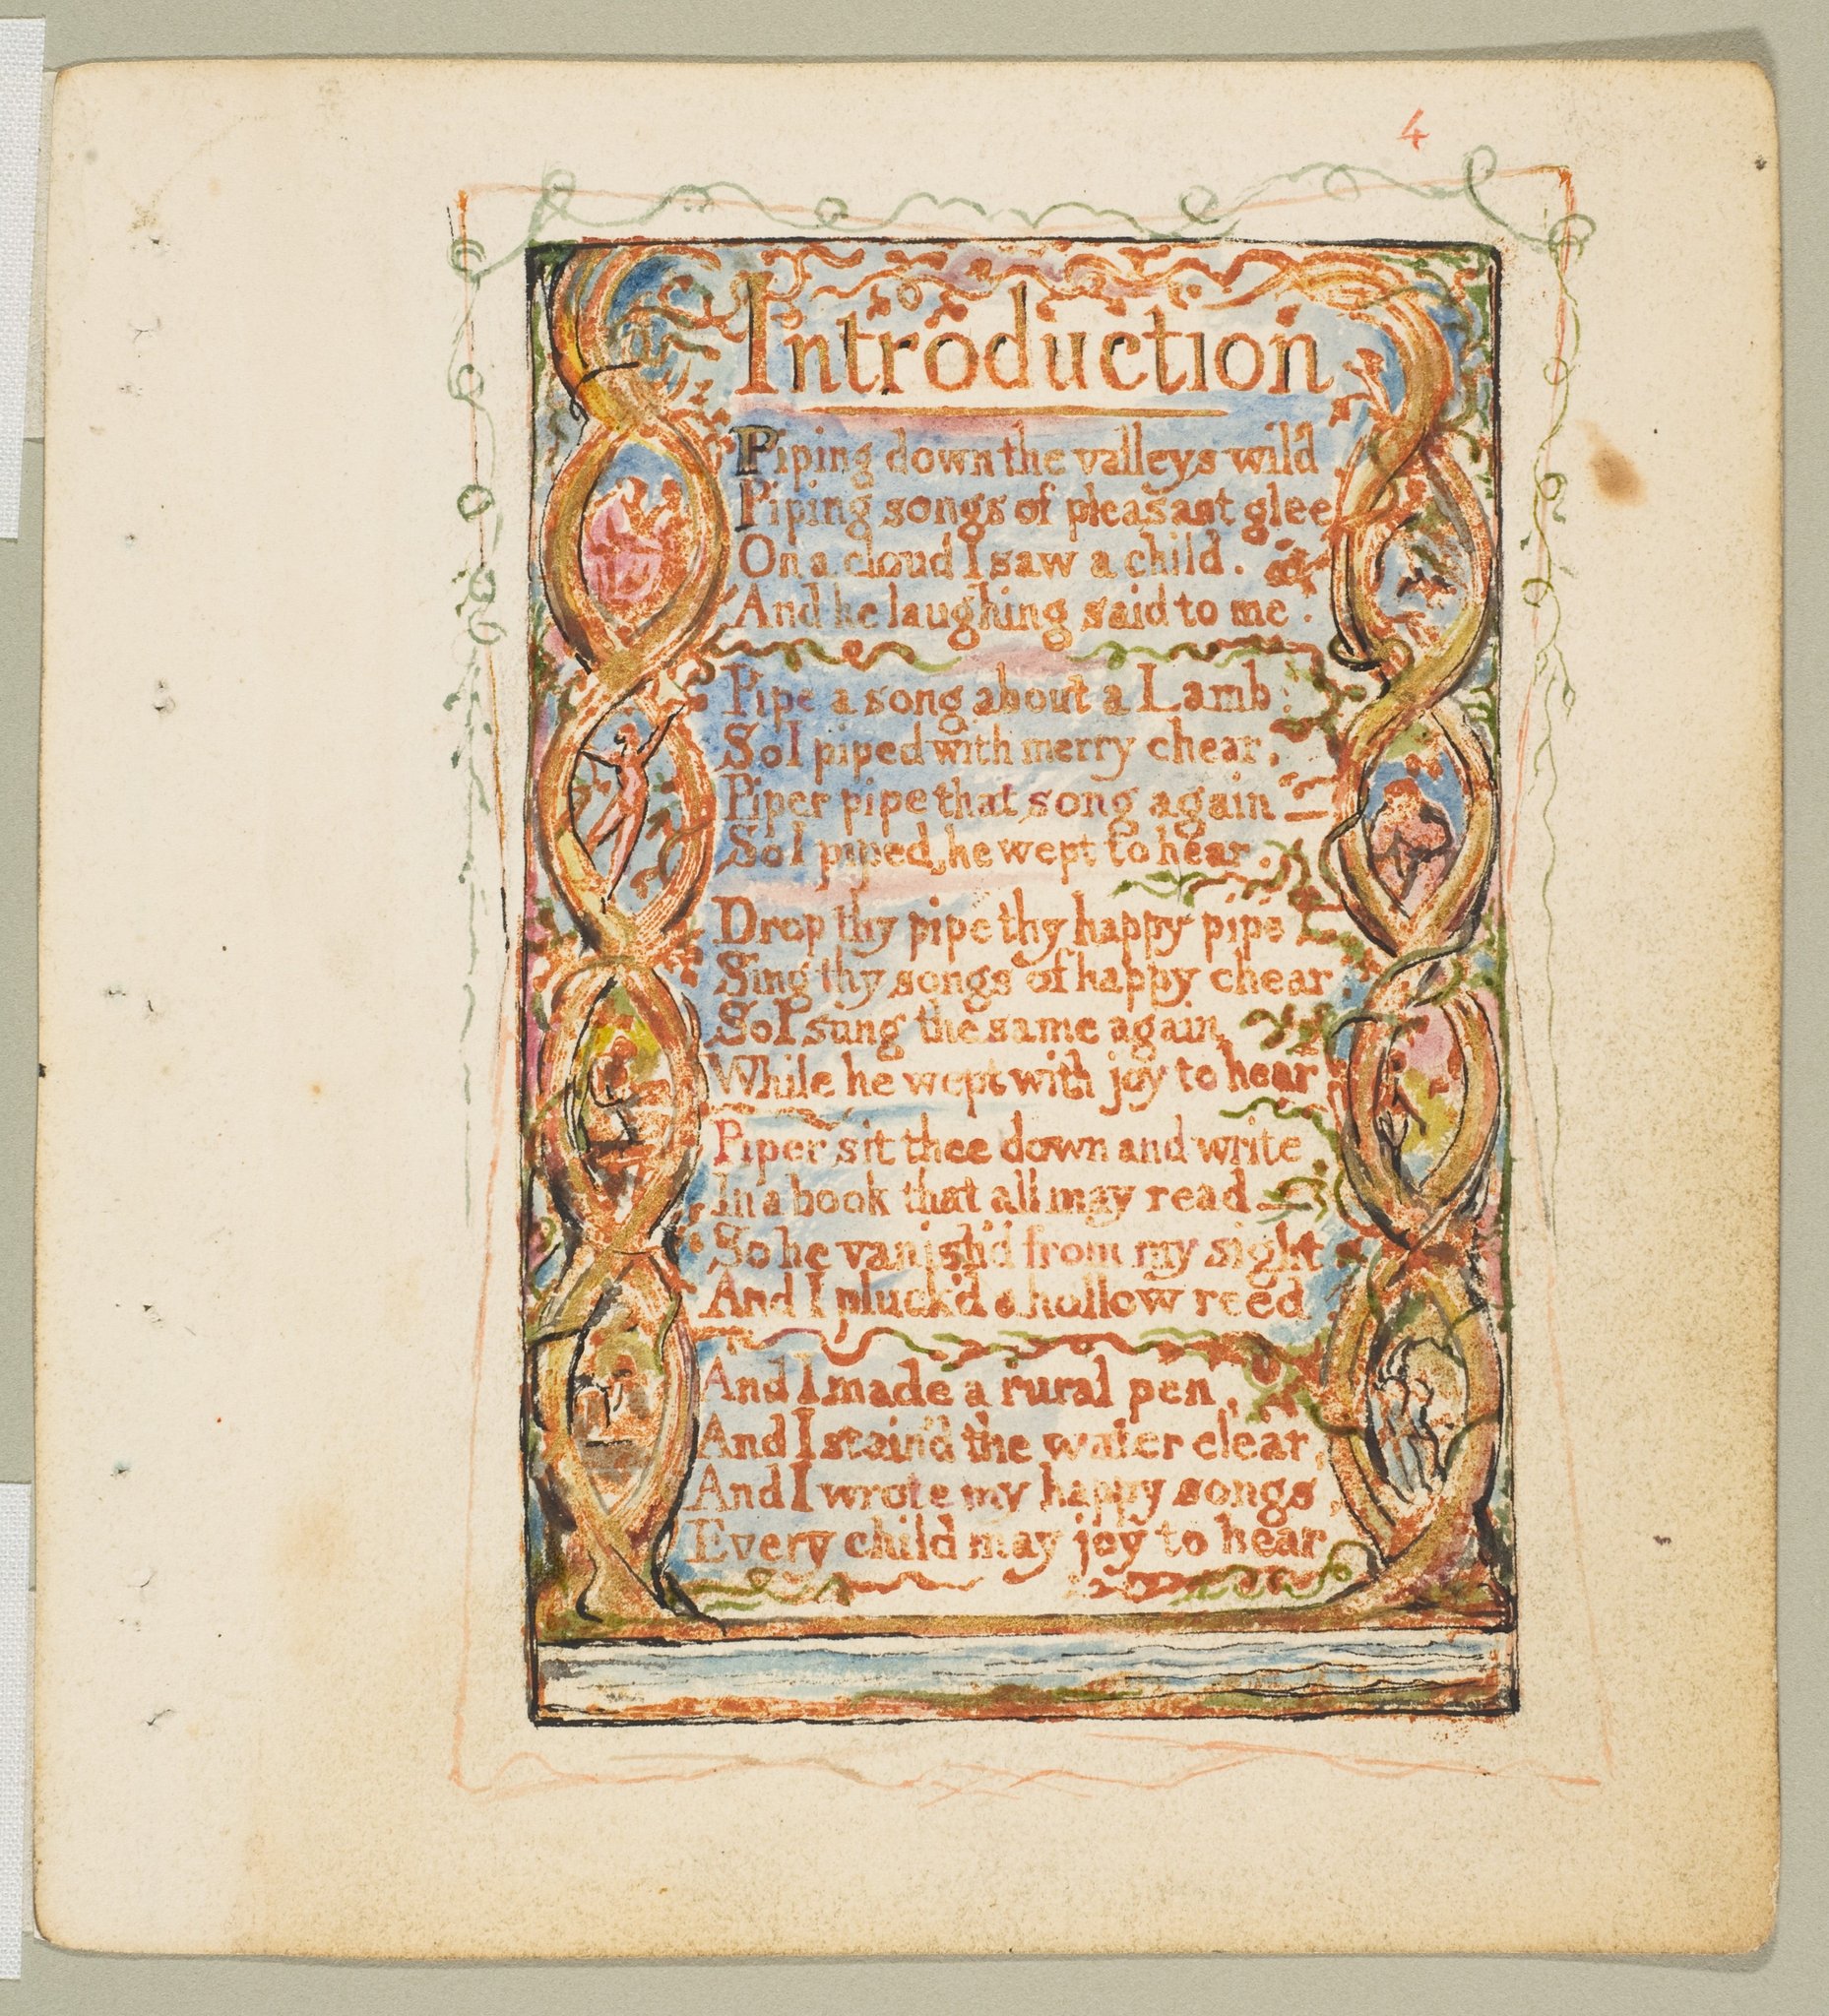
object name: print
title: Songs of Innocence: Introduction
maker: william blake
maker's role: artist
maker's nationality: british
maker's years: 1757-1827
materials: gold, ink, shell, watercolor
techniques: etching, hand coloring, printing, relief